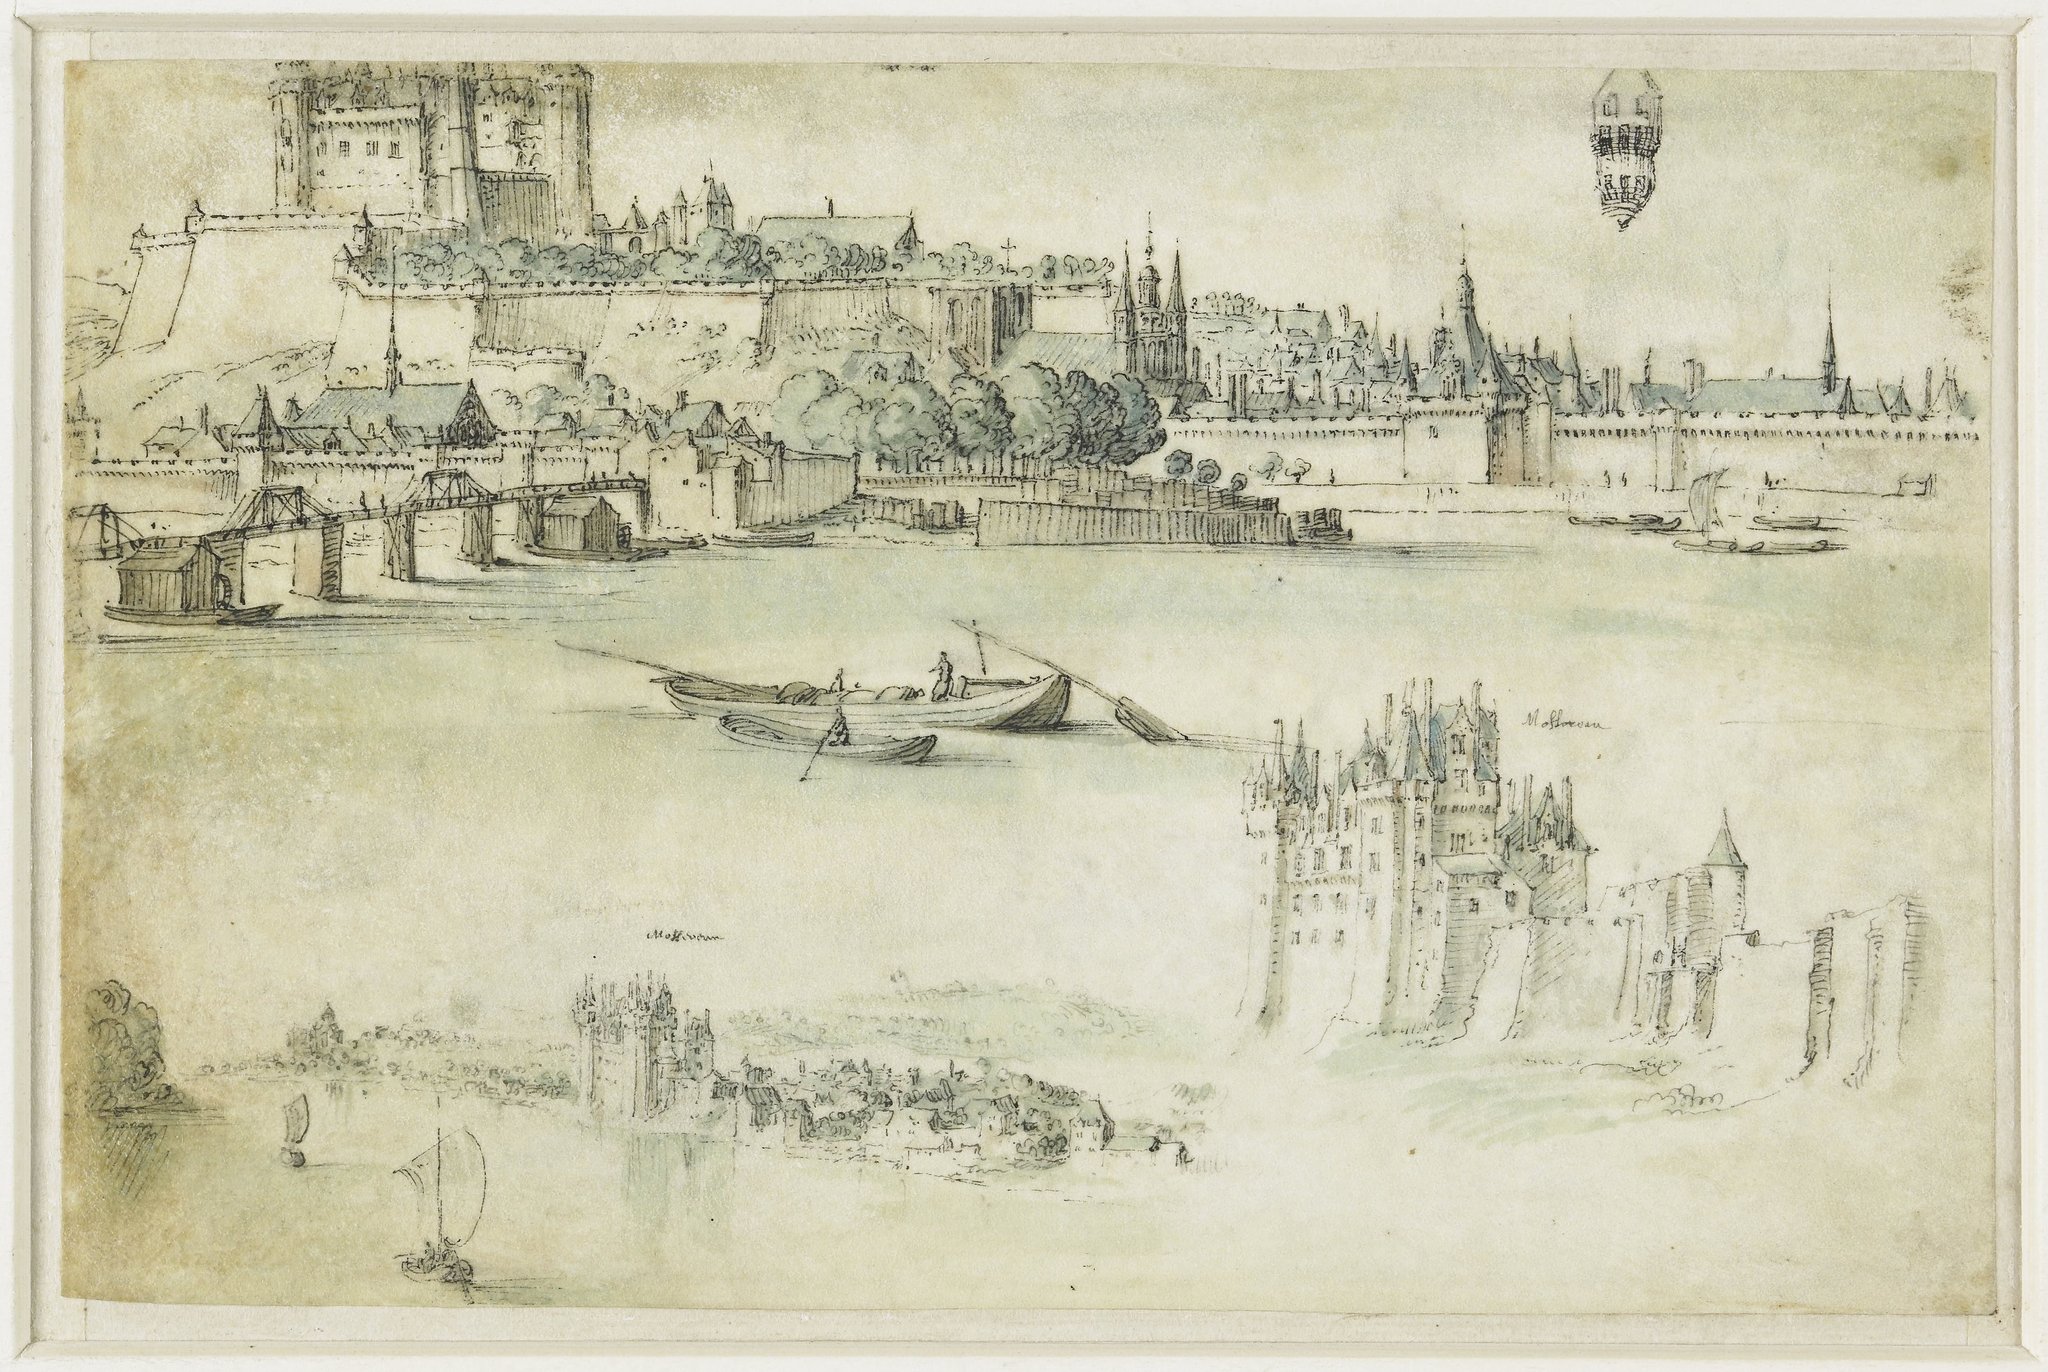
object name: watercolor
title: Loire-landschap met de kastelen Saumur en Montsoreau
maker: Anonymous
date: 1600-1650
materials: ink, parchment, watercolor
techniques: brush, pen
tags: castle, river (+ landscape with figures, staffage)